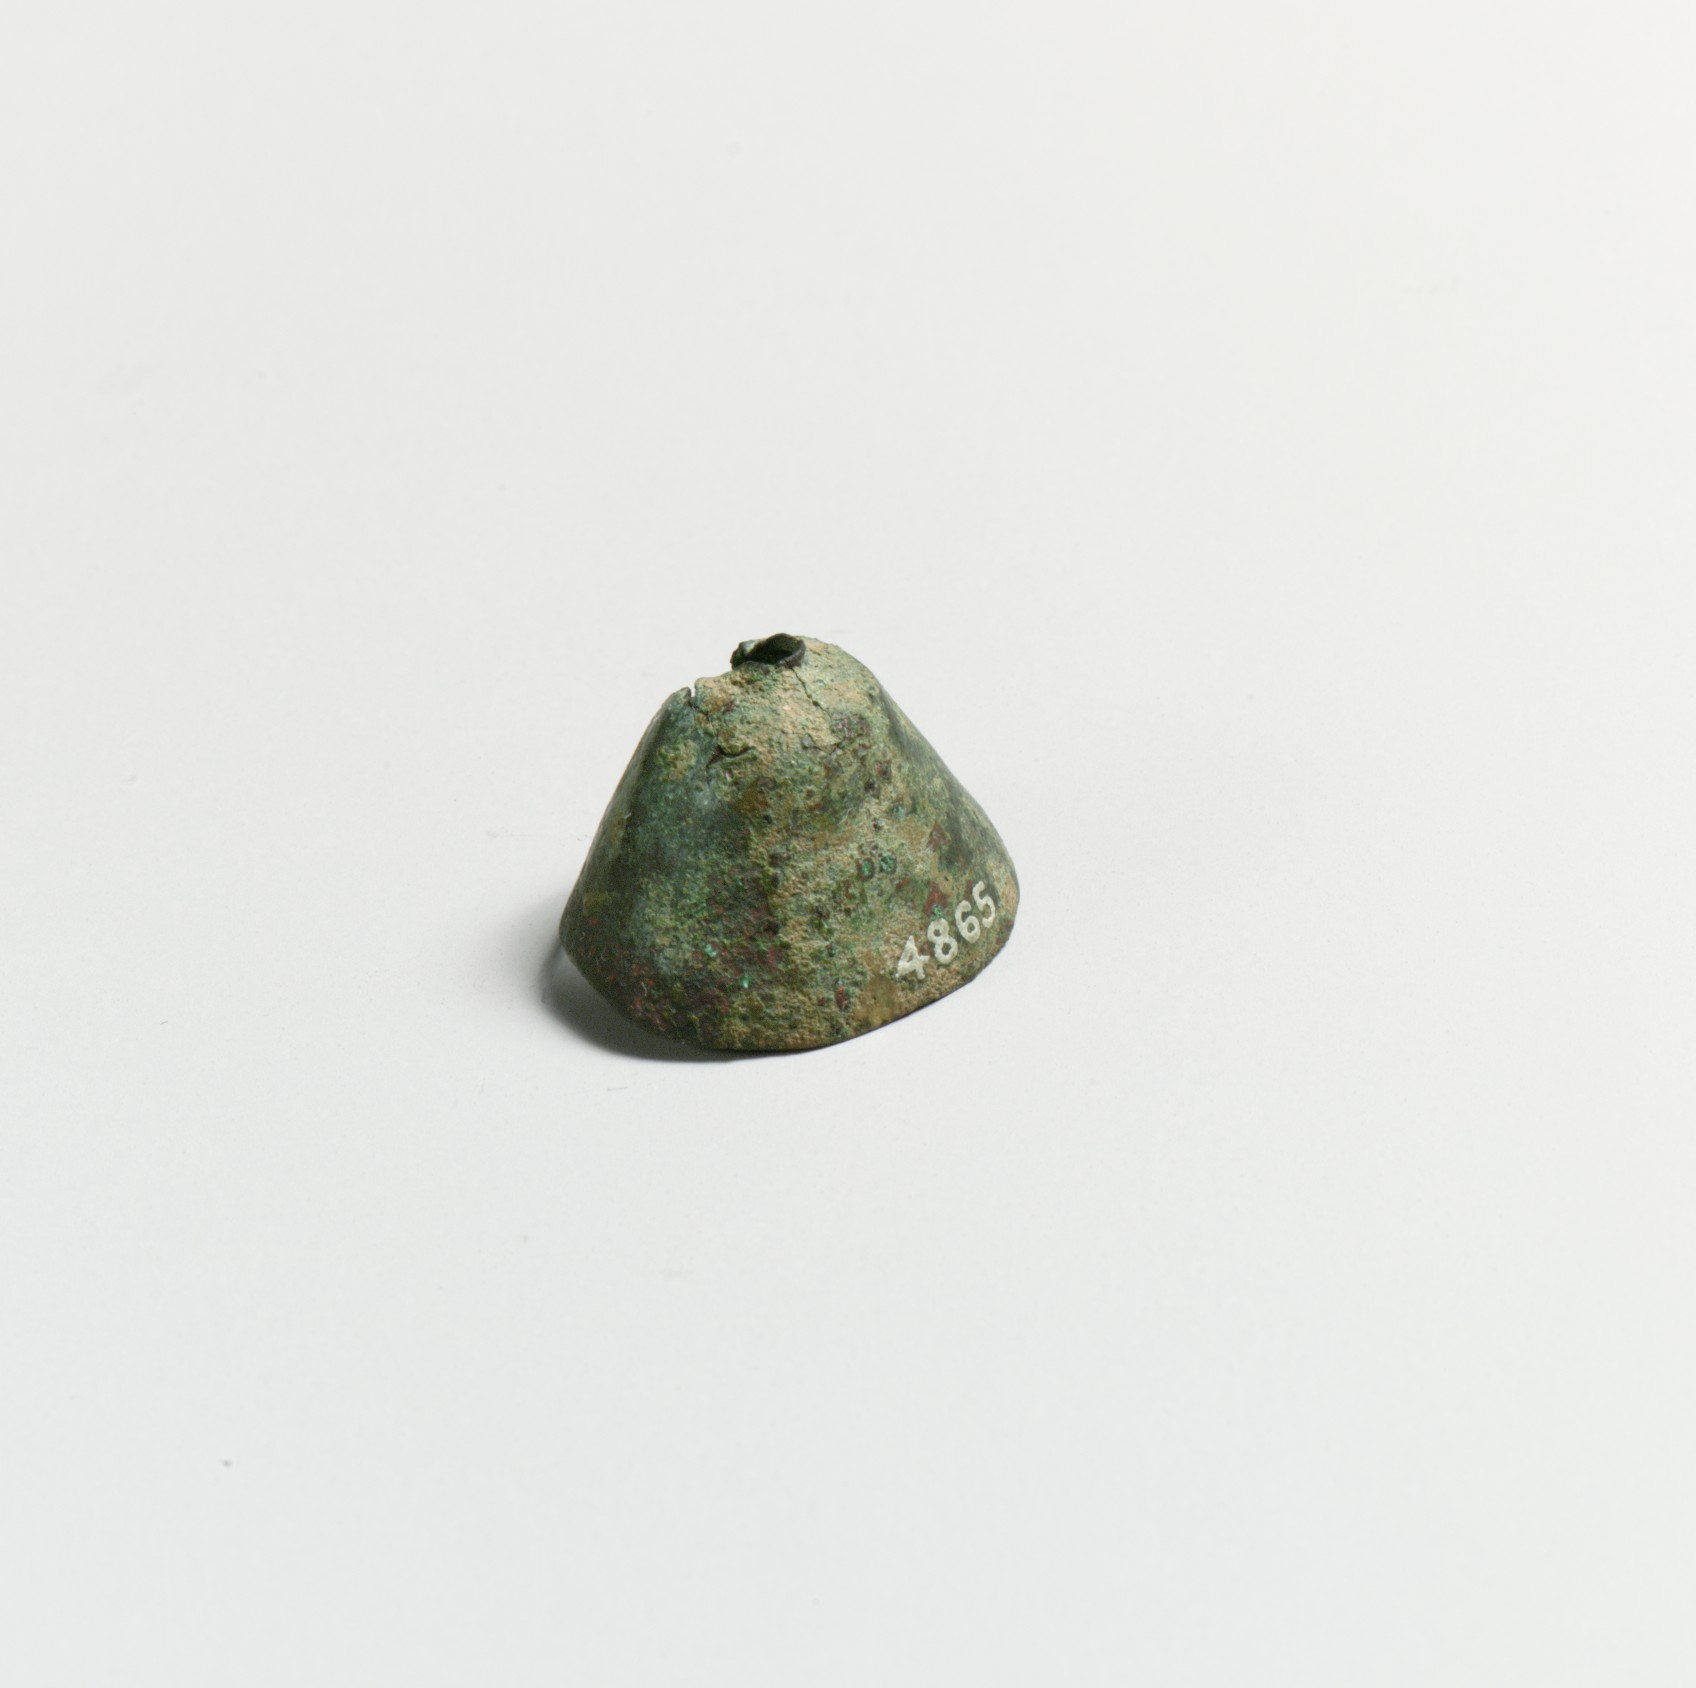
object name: bell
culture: cypriot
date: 400-301 BCE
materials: bronze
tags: musical instruments